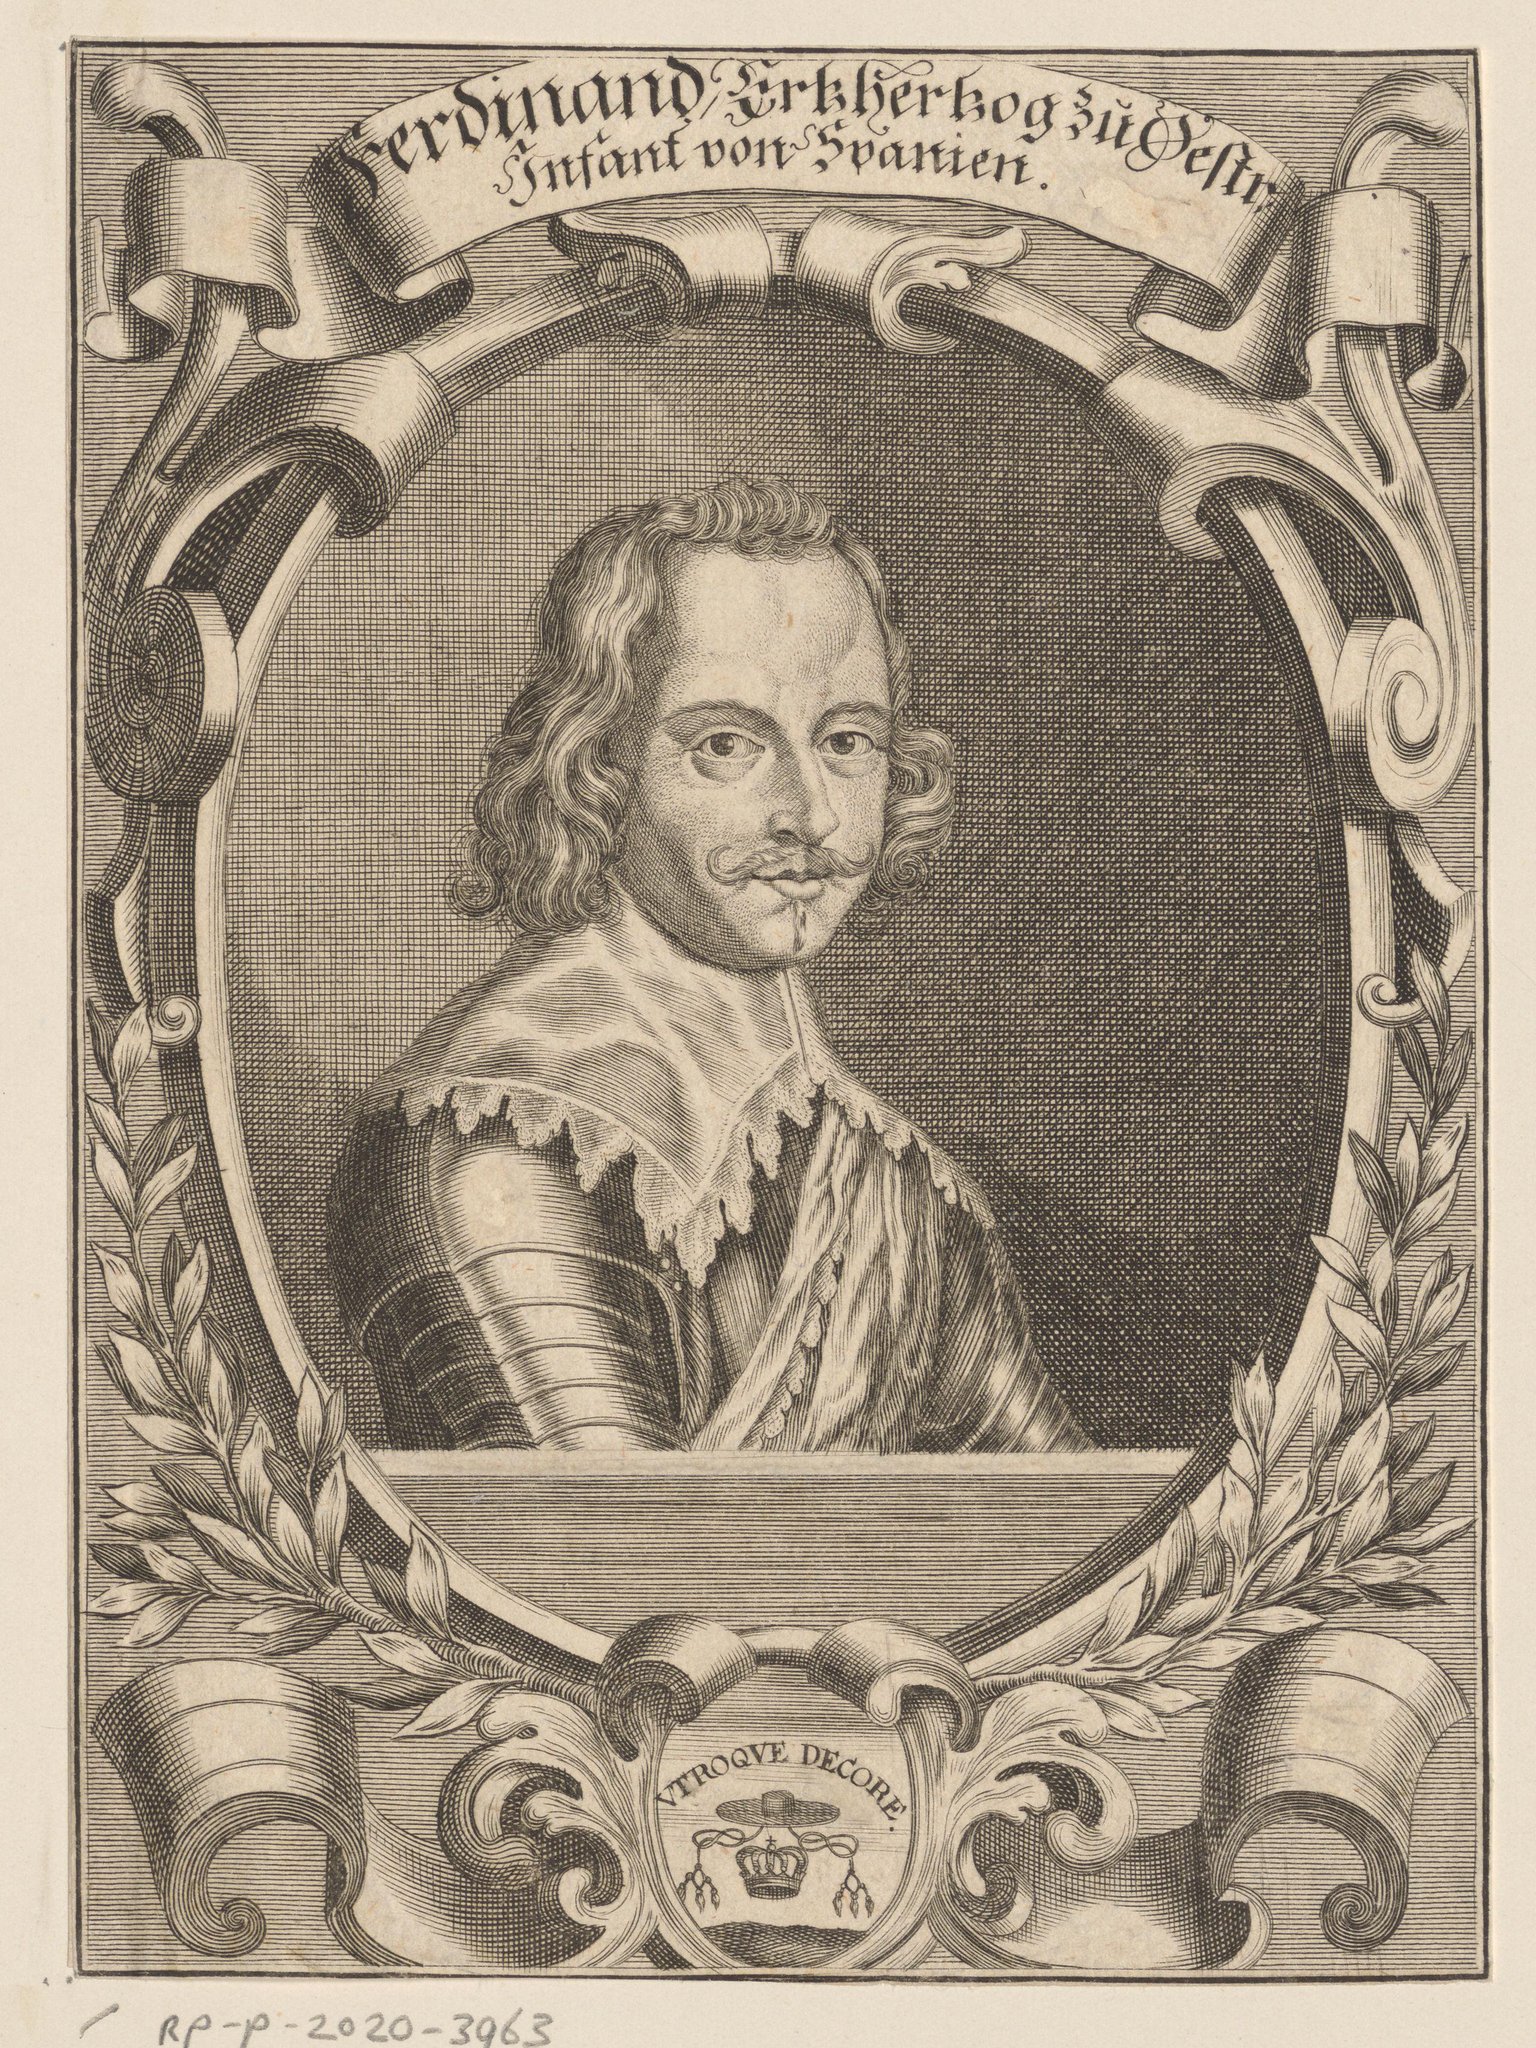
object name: print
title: Portret van Ferdinand van Oostenrijk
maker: Anonymous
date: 1625-1680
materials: paper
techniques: engraving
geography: germany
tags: brussels, landvoogd der zuidelijke nederlanden ferdinand van oostenrijk, historical persons, armorial bearing, heraldry